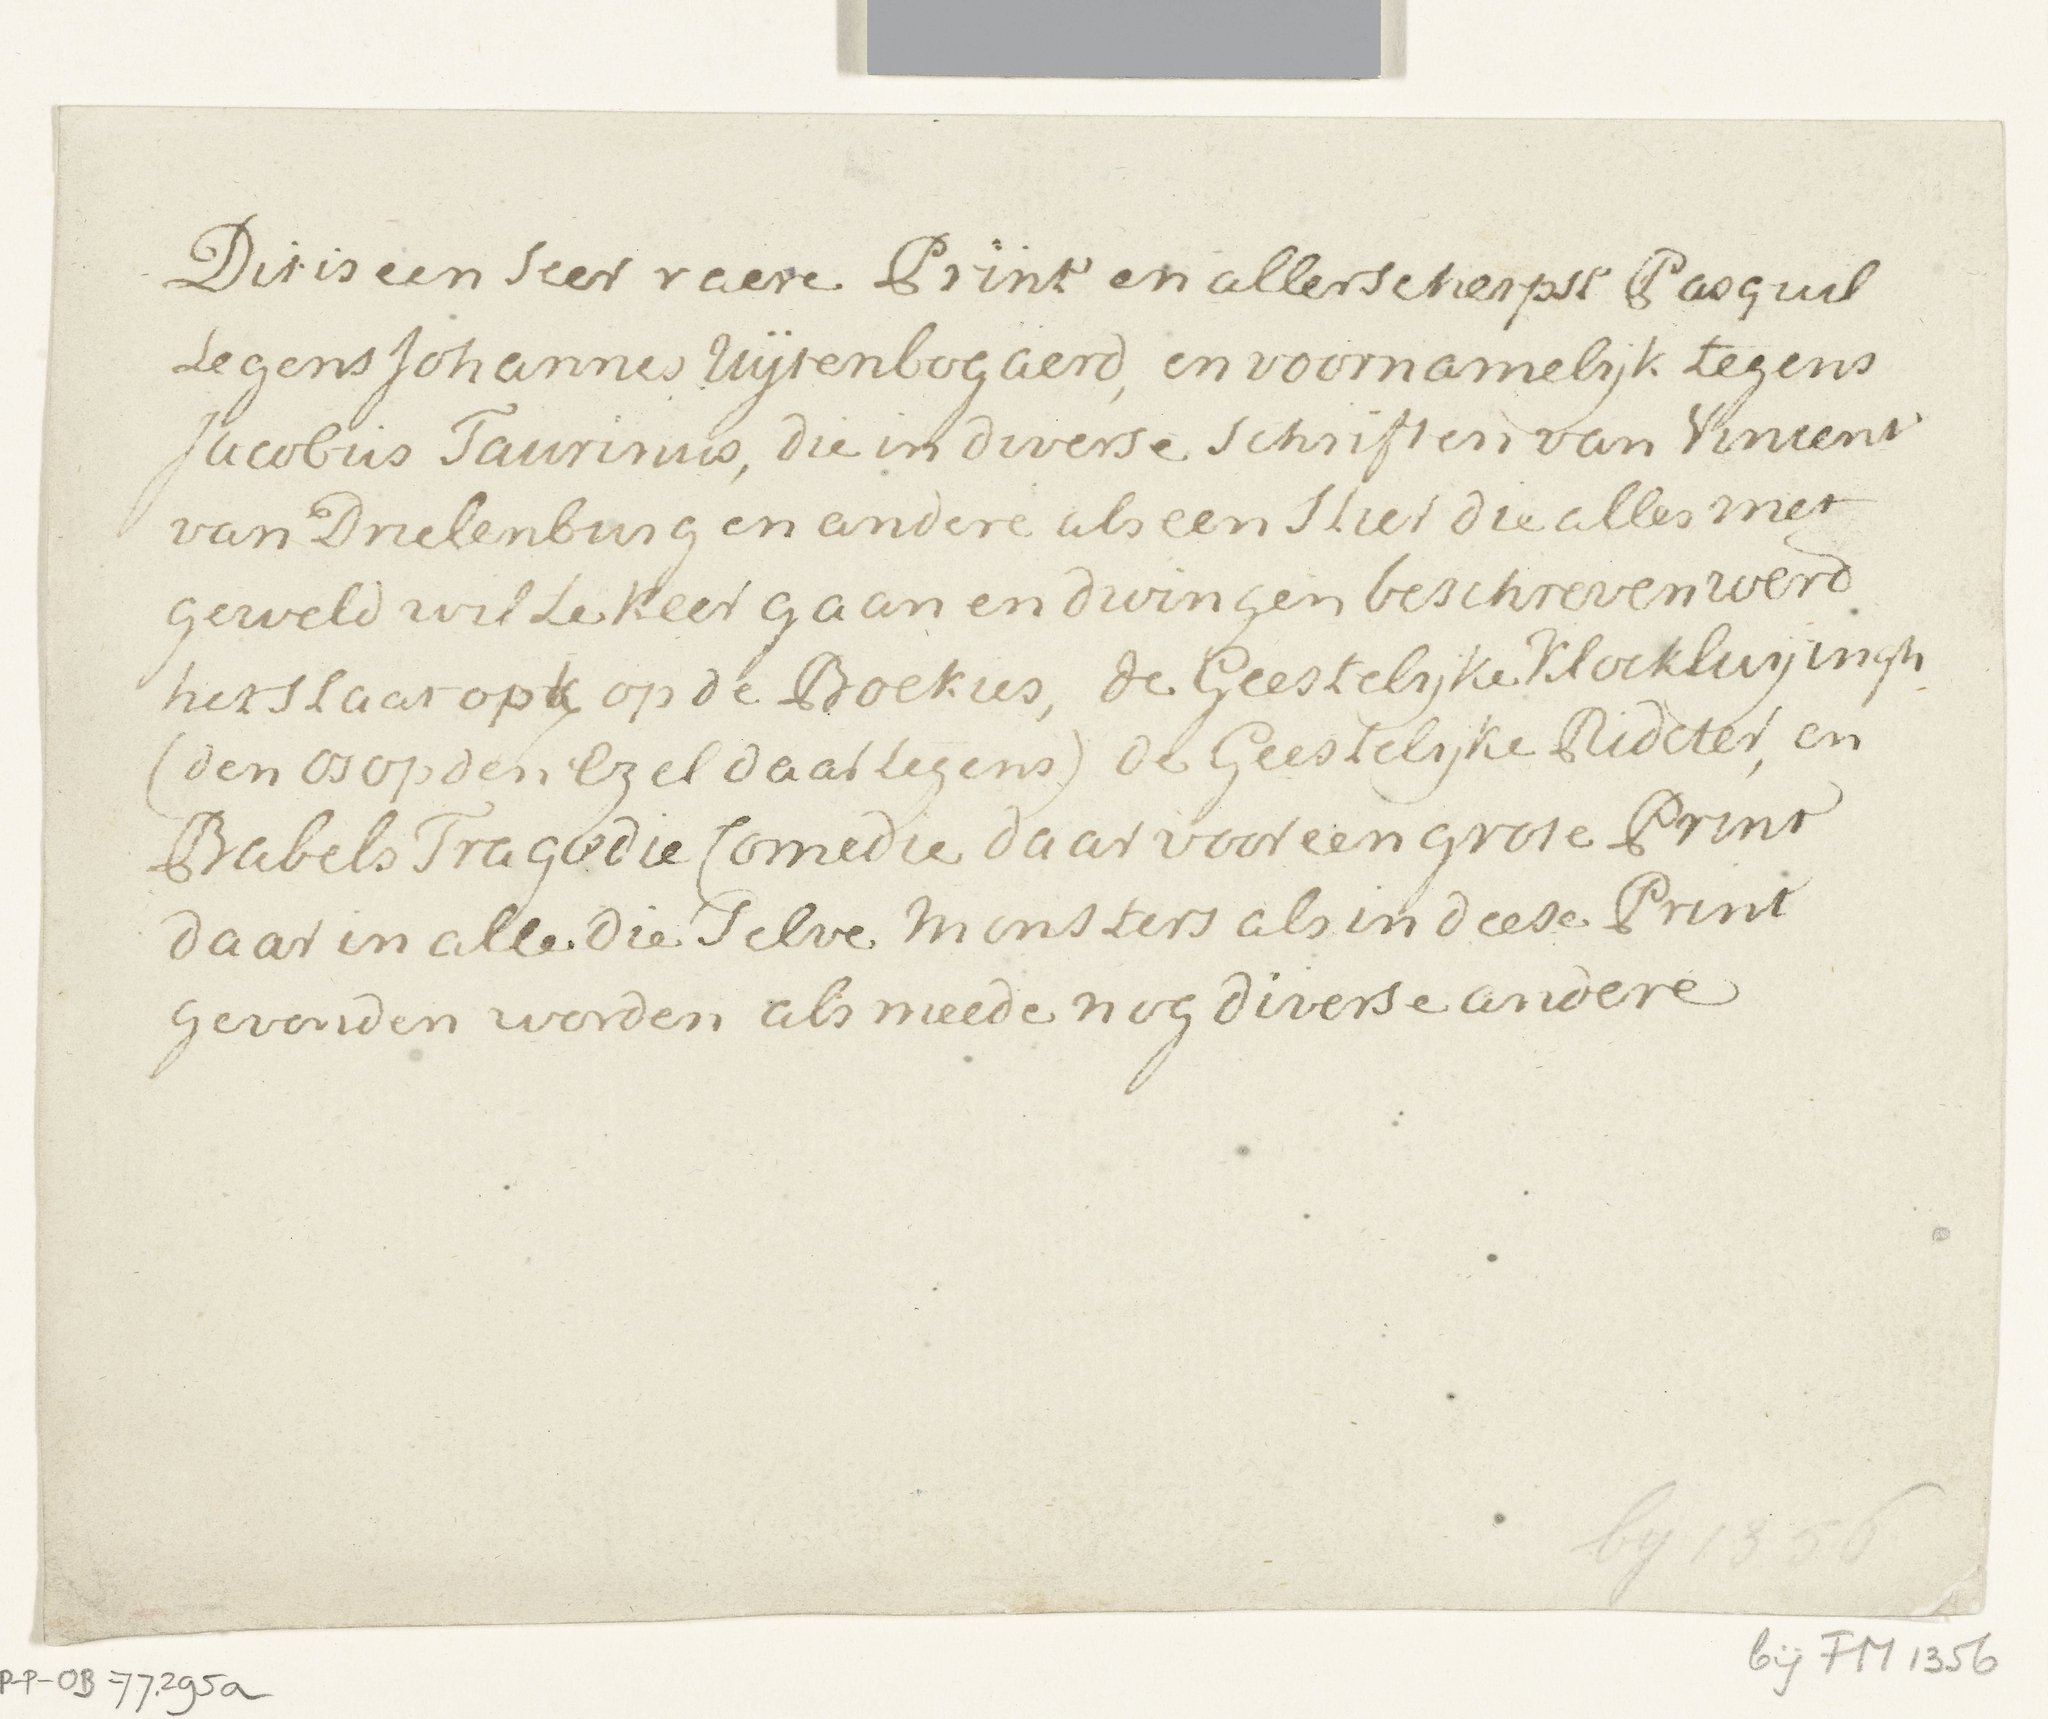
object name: manuscript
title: Handschrift over de spotprent op Taurinus (1615)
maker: Anonymous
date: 1800-1899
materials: ink, paper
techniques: pen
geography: netherlands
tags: antwerp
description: Handschrift over de spotprent op de Utrechtse remonstrantse predikant Jacobus Taurinus (FM 1356) uit 1615. Korte tekst waarin de anonieme auteur zijn vermoedens uit dat de prent behoort bij één van de geschriften tegen Taurinus.